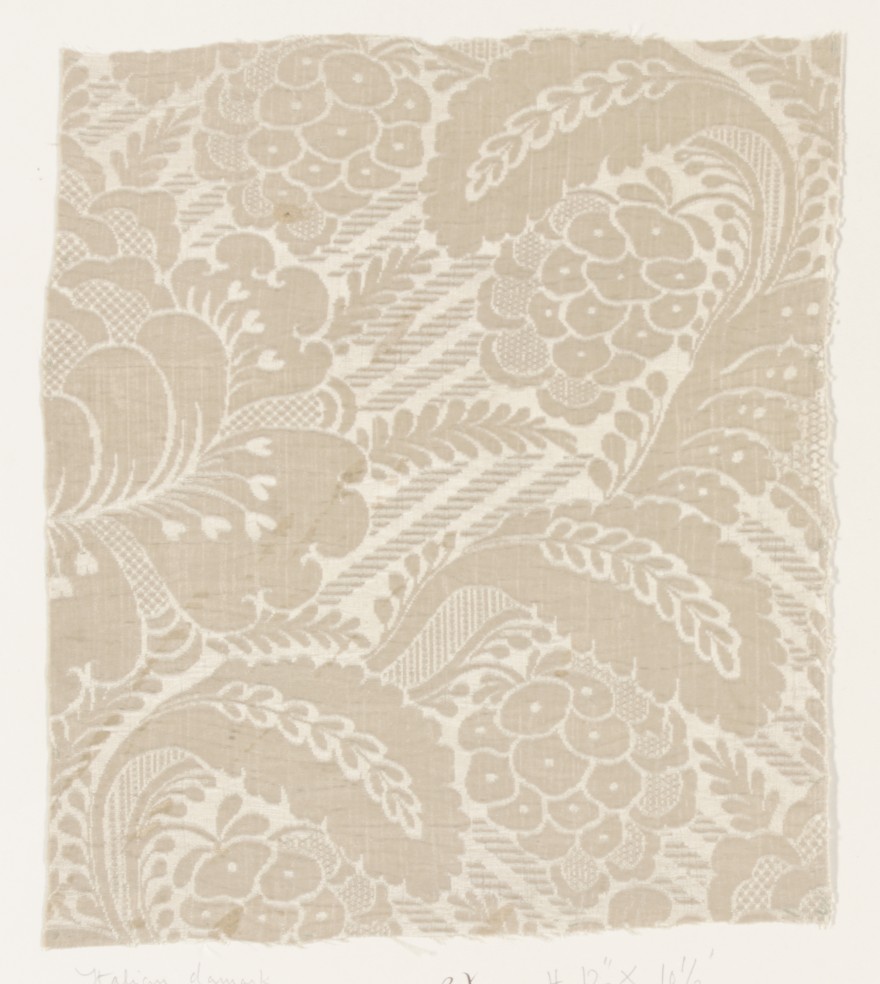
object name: fragment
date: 1601-1800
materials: silk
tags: leaves